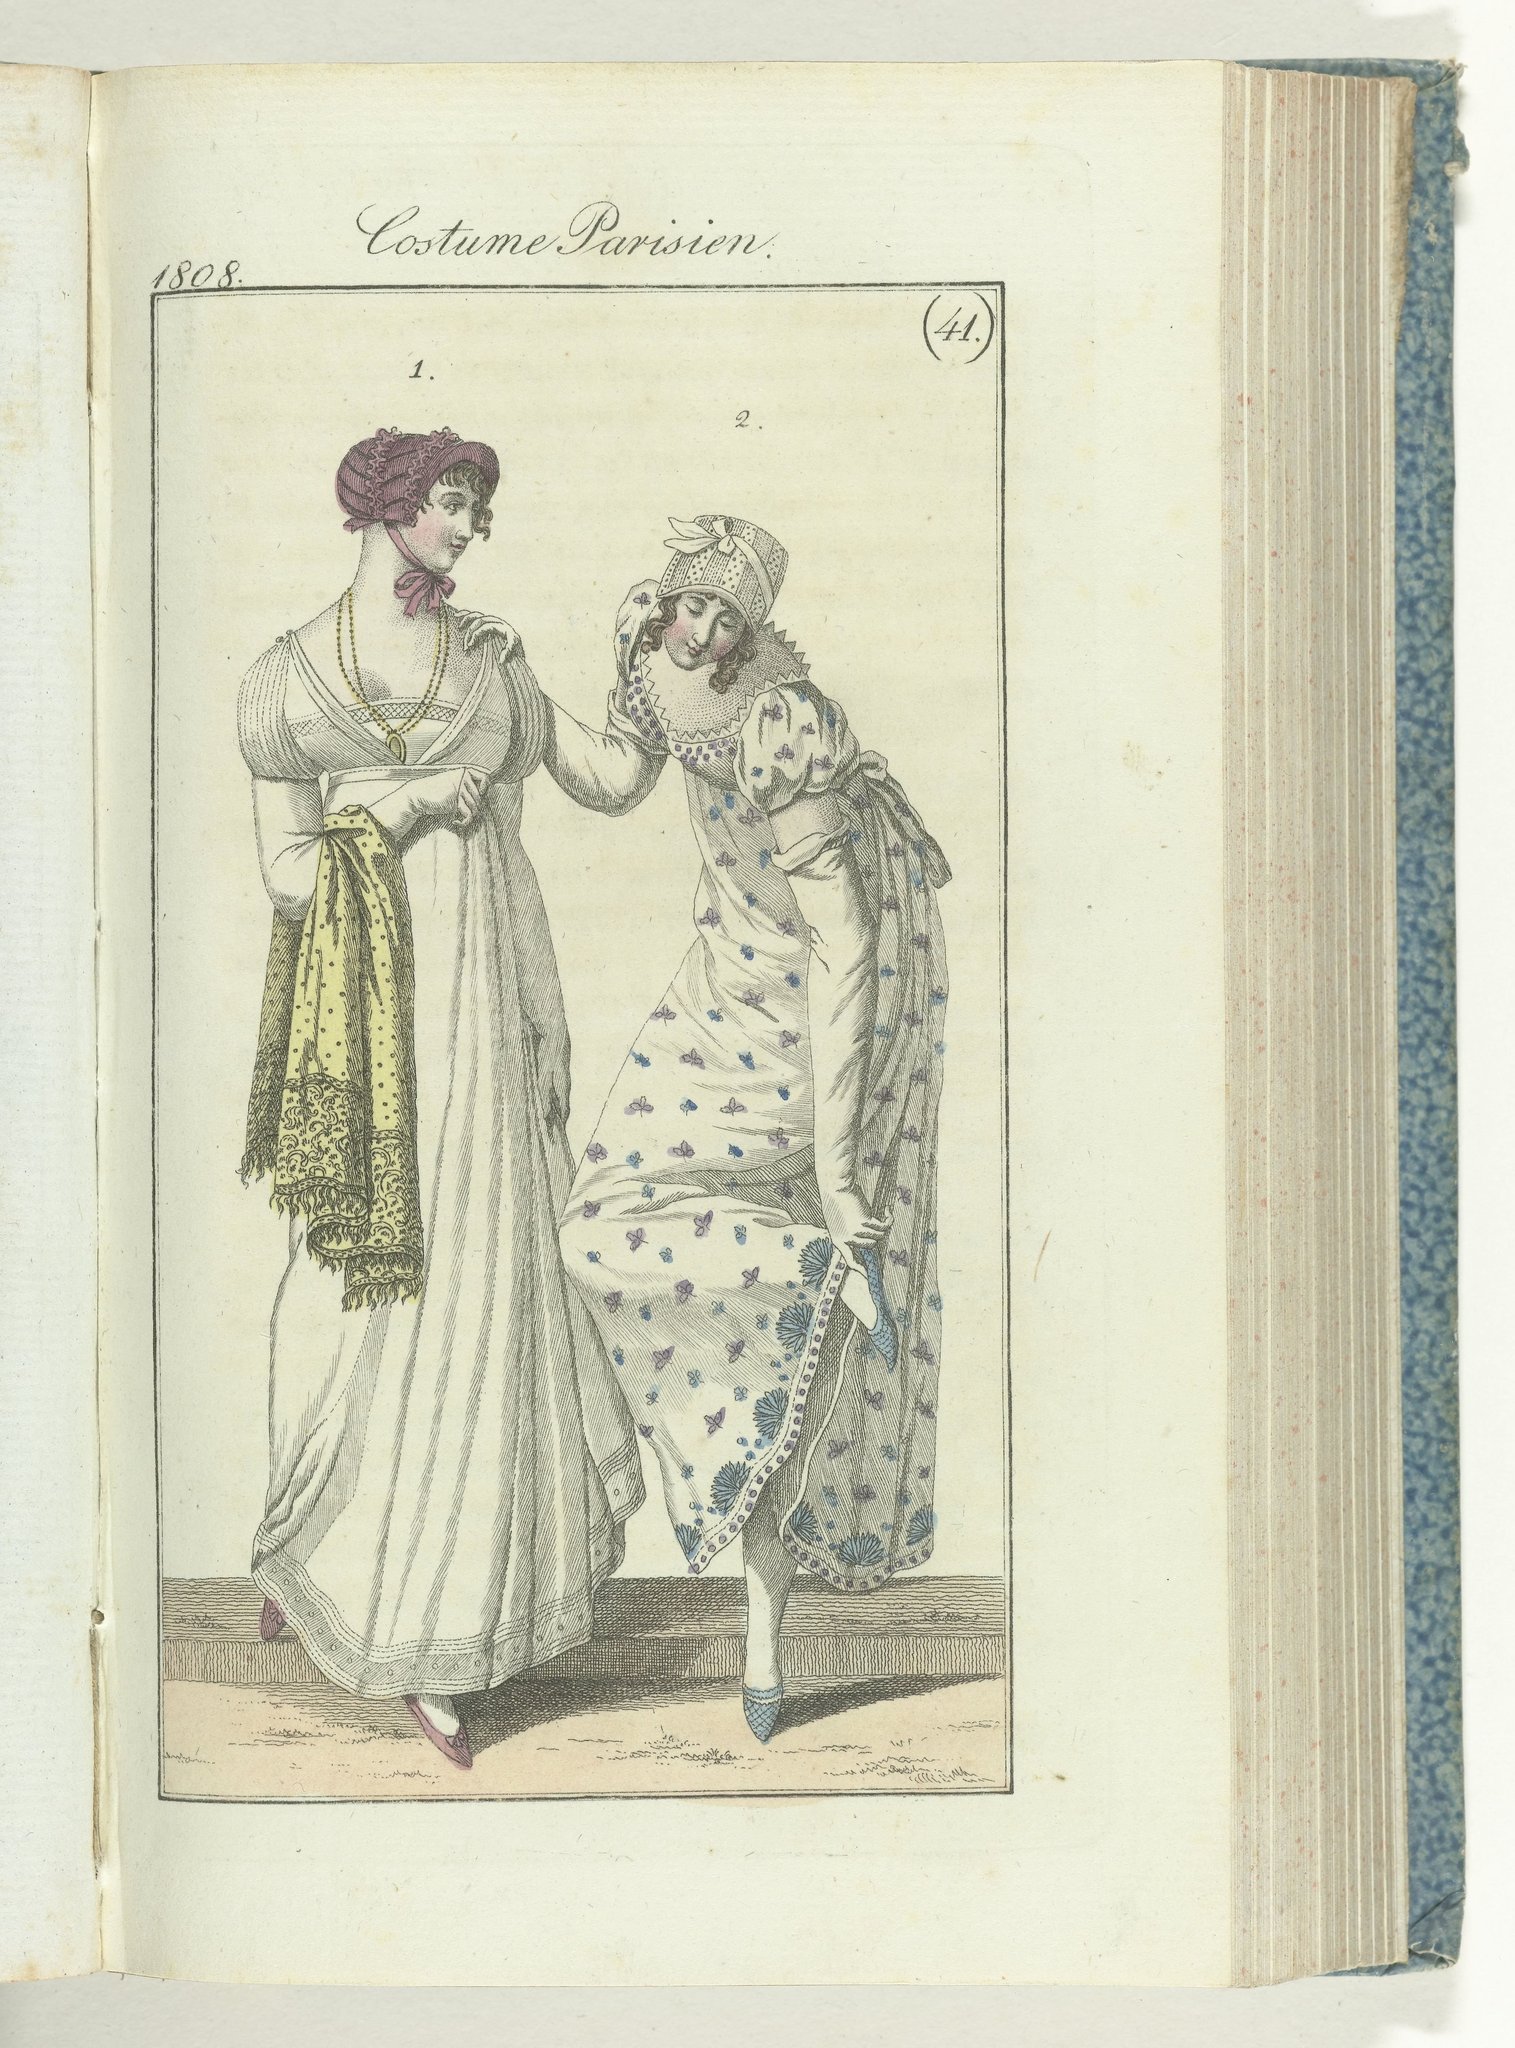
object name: magazine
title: Journal des Dames et des Modes, editie Frankfurt 9 octobre 1808, Costume Parisien (41)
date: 1808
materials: paper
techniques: engraving, hand coloring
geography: frankfurt am main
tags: clothing for the upper part of the body (shawl) (+ women's clothes), styles of hairdress - aa - ~ women, fashion plates, head-gear: hat (+ women's clothes), shoes, sandals (+ women's clothes), dress, gown (+ women's clothes), necklace (+ women's clothes)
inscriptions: title: ‘Costume Parisien.’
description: De begeleidende tekst (p. 52) vermeldt: Fig. 1: Kleine hoed van tafzijde 'à liserés et double bande froncée'. Ketting van amber. Japon en ceintuur van perkale. Gele sjaal met nopjes. Witte handschoenen. Violette schoenen. Fig. 2: Hoofddeksel van stroken tule 'et de remplis'. Japon van bedrukte perkale. Witte handschoenen. Blauwe schoenen. De prent maakt deel uit van het modetijdschrift Journal des Dames et des Modes, uitgegeven in Frankfurt als kopie van de Franse editie van Pierre de la Mésangère, (1798-1848).